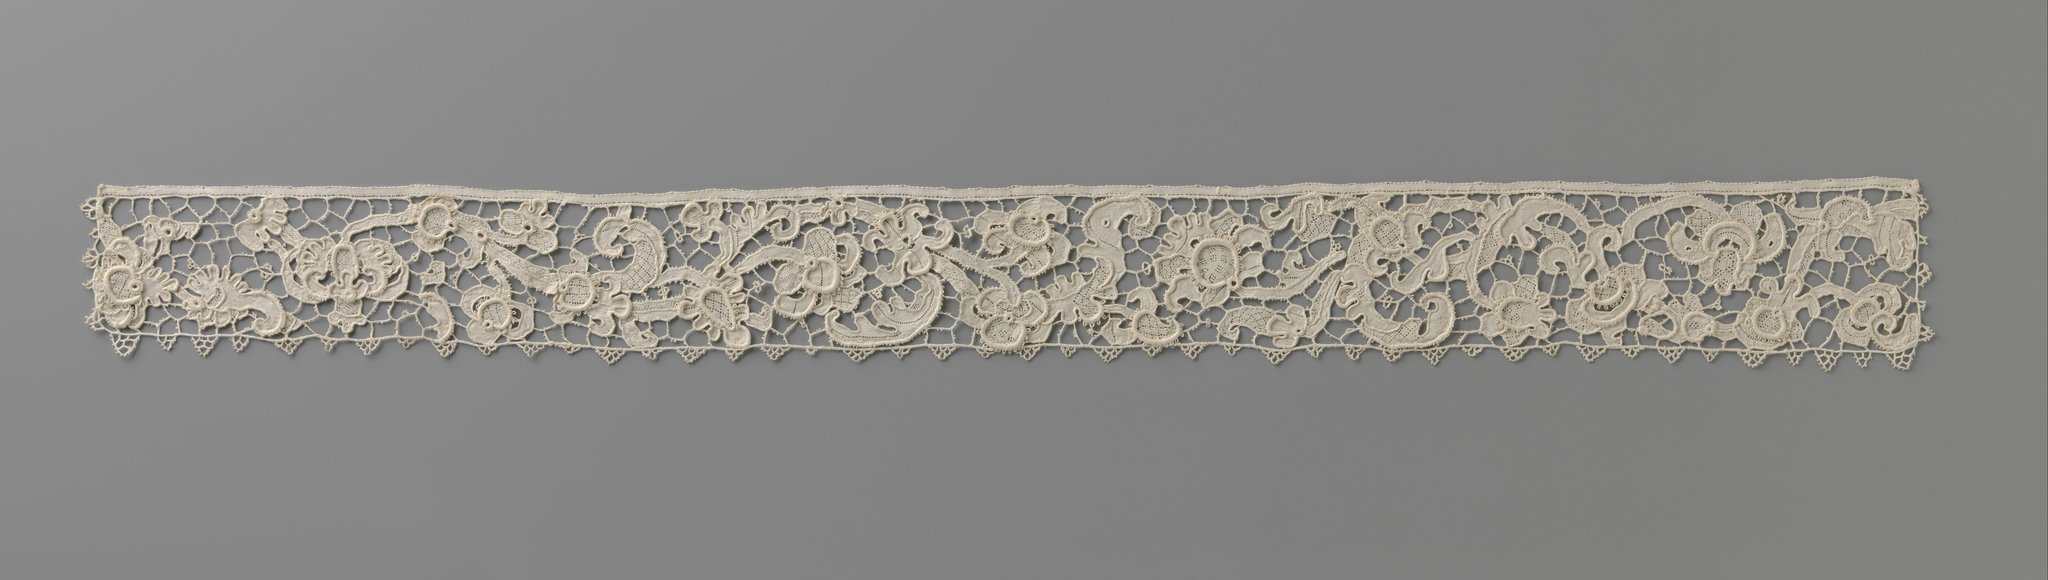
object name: strip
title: Strook naaldkant met gestrekte S-rank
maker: Anonymous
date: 1600-1699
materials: linen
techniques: embroidery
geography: burano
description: Mogelijk nog samengesteld uit 17e-eeuwse stukken, waaraan vernieuwingen zijn aangebracht in de 19e eeuw, zoals bijvoorbeeld het zeer los geschikte patroon, dat op het open fond staat. De veellobbige bloem- en bladranden zijn zeker 19e-eeuwse toevoegingen.